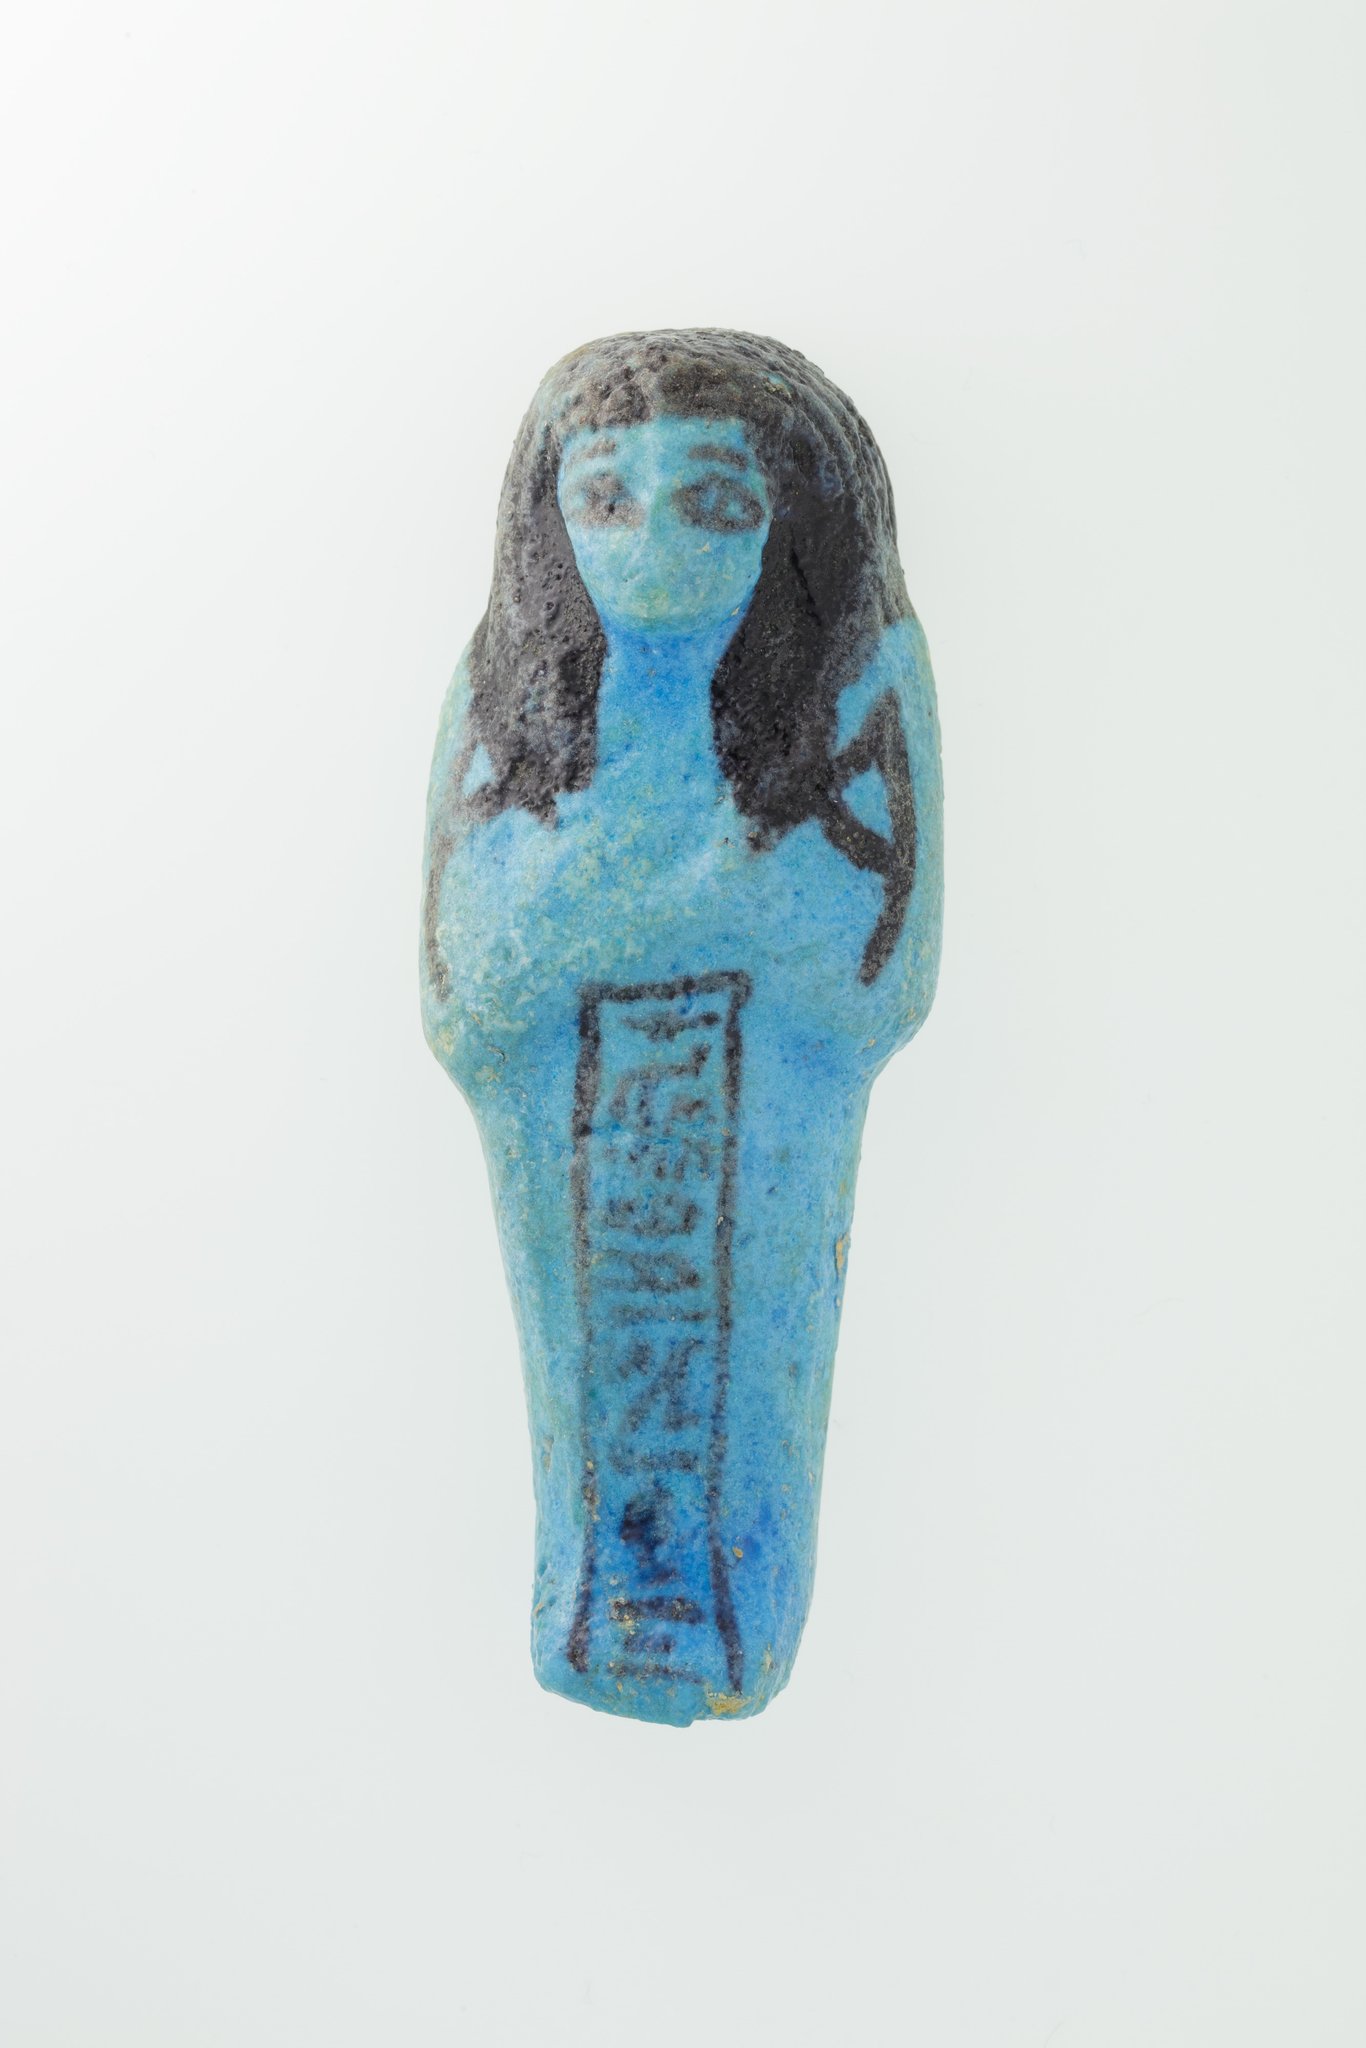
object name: shabti, worker, nauny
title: Worker Shabti of Nauny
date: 1050 BCE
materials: faience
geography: egypt